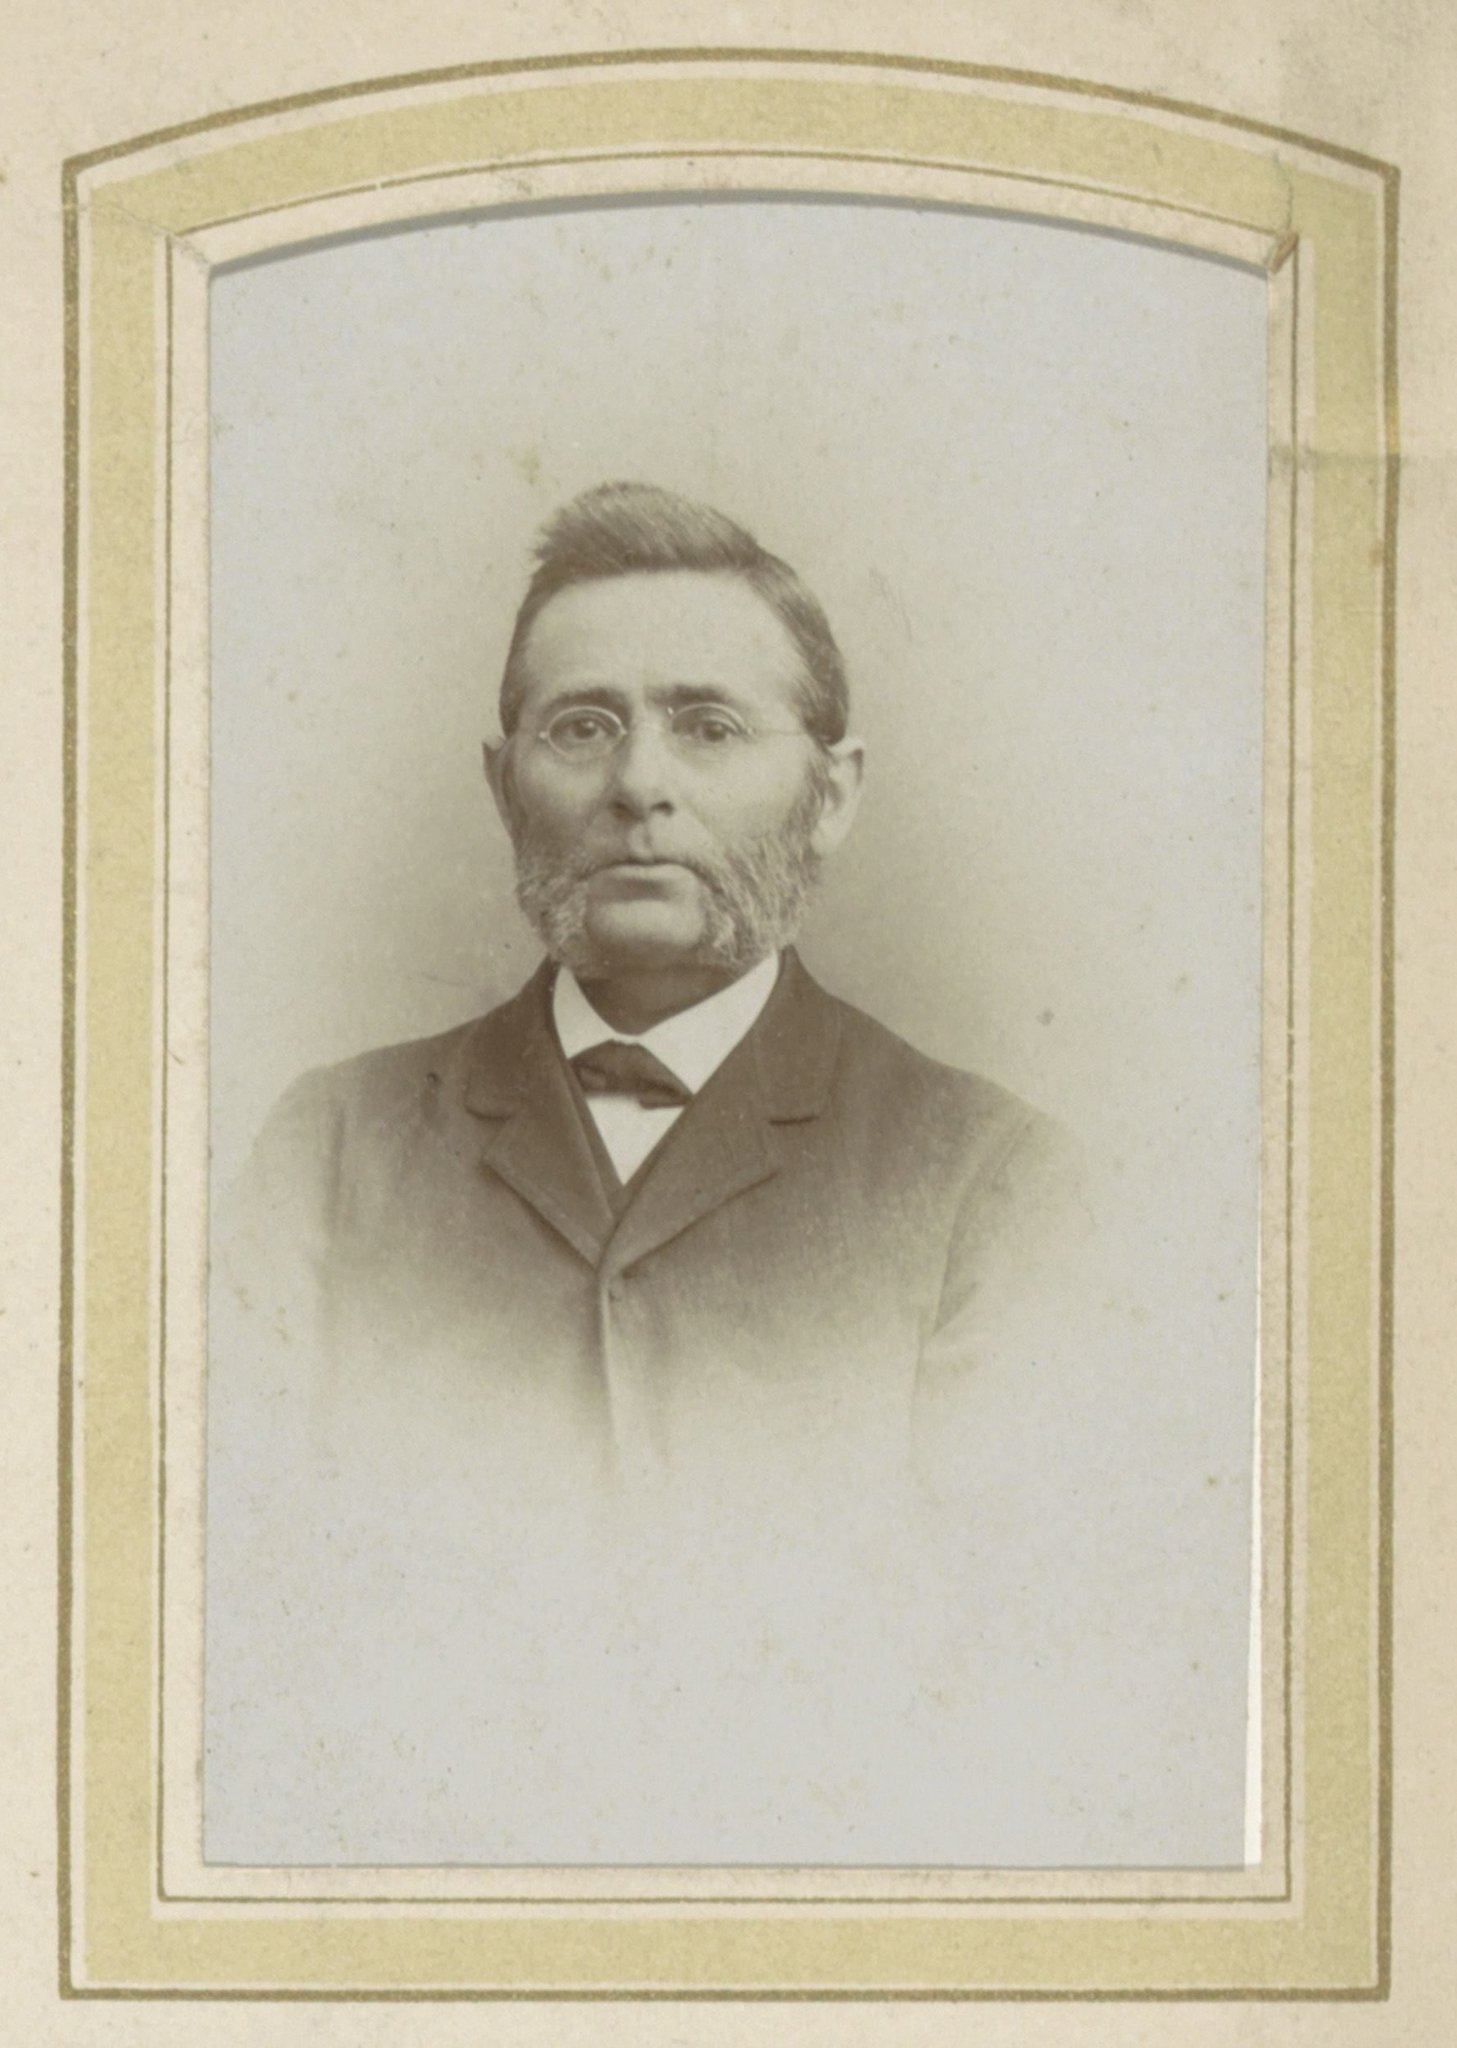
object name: carte de visite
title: Portret van een man met een bril en bakkebaarden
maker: johan christiaan reesinck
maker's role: fotograaf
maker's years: 1838-1922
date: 1866-1900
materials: cardboard, paper, photographic support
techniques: collodion silver print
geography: netherlands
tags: eyeglasses, spectacles, sideburns, historical persons, clothing for the upper part of the body, netherlands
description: Onderdeel van Fotoalbum van een Nederlandse familie met 168 cartes-de-visite en kabinetfoto's.